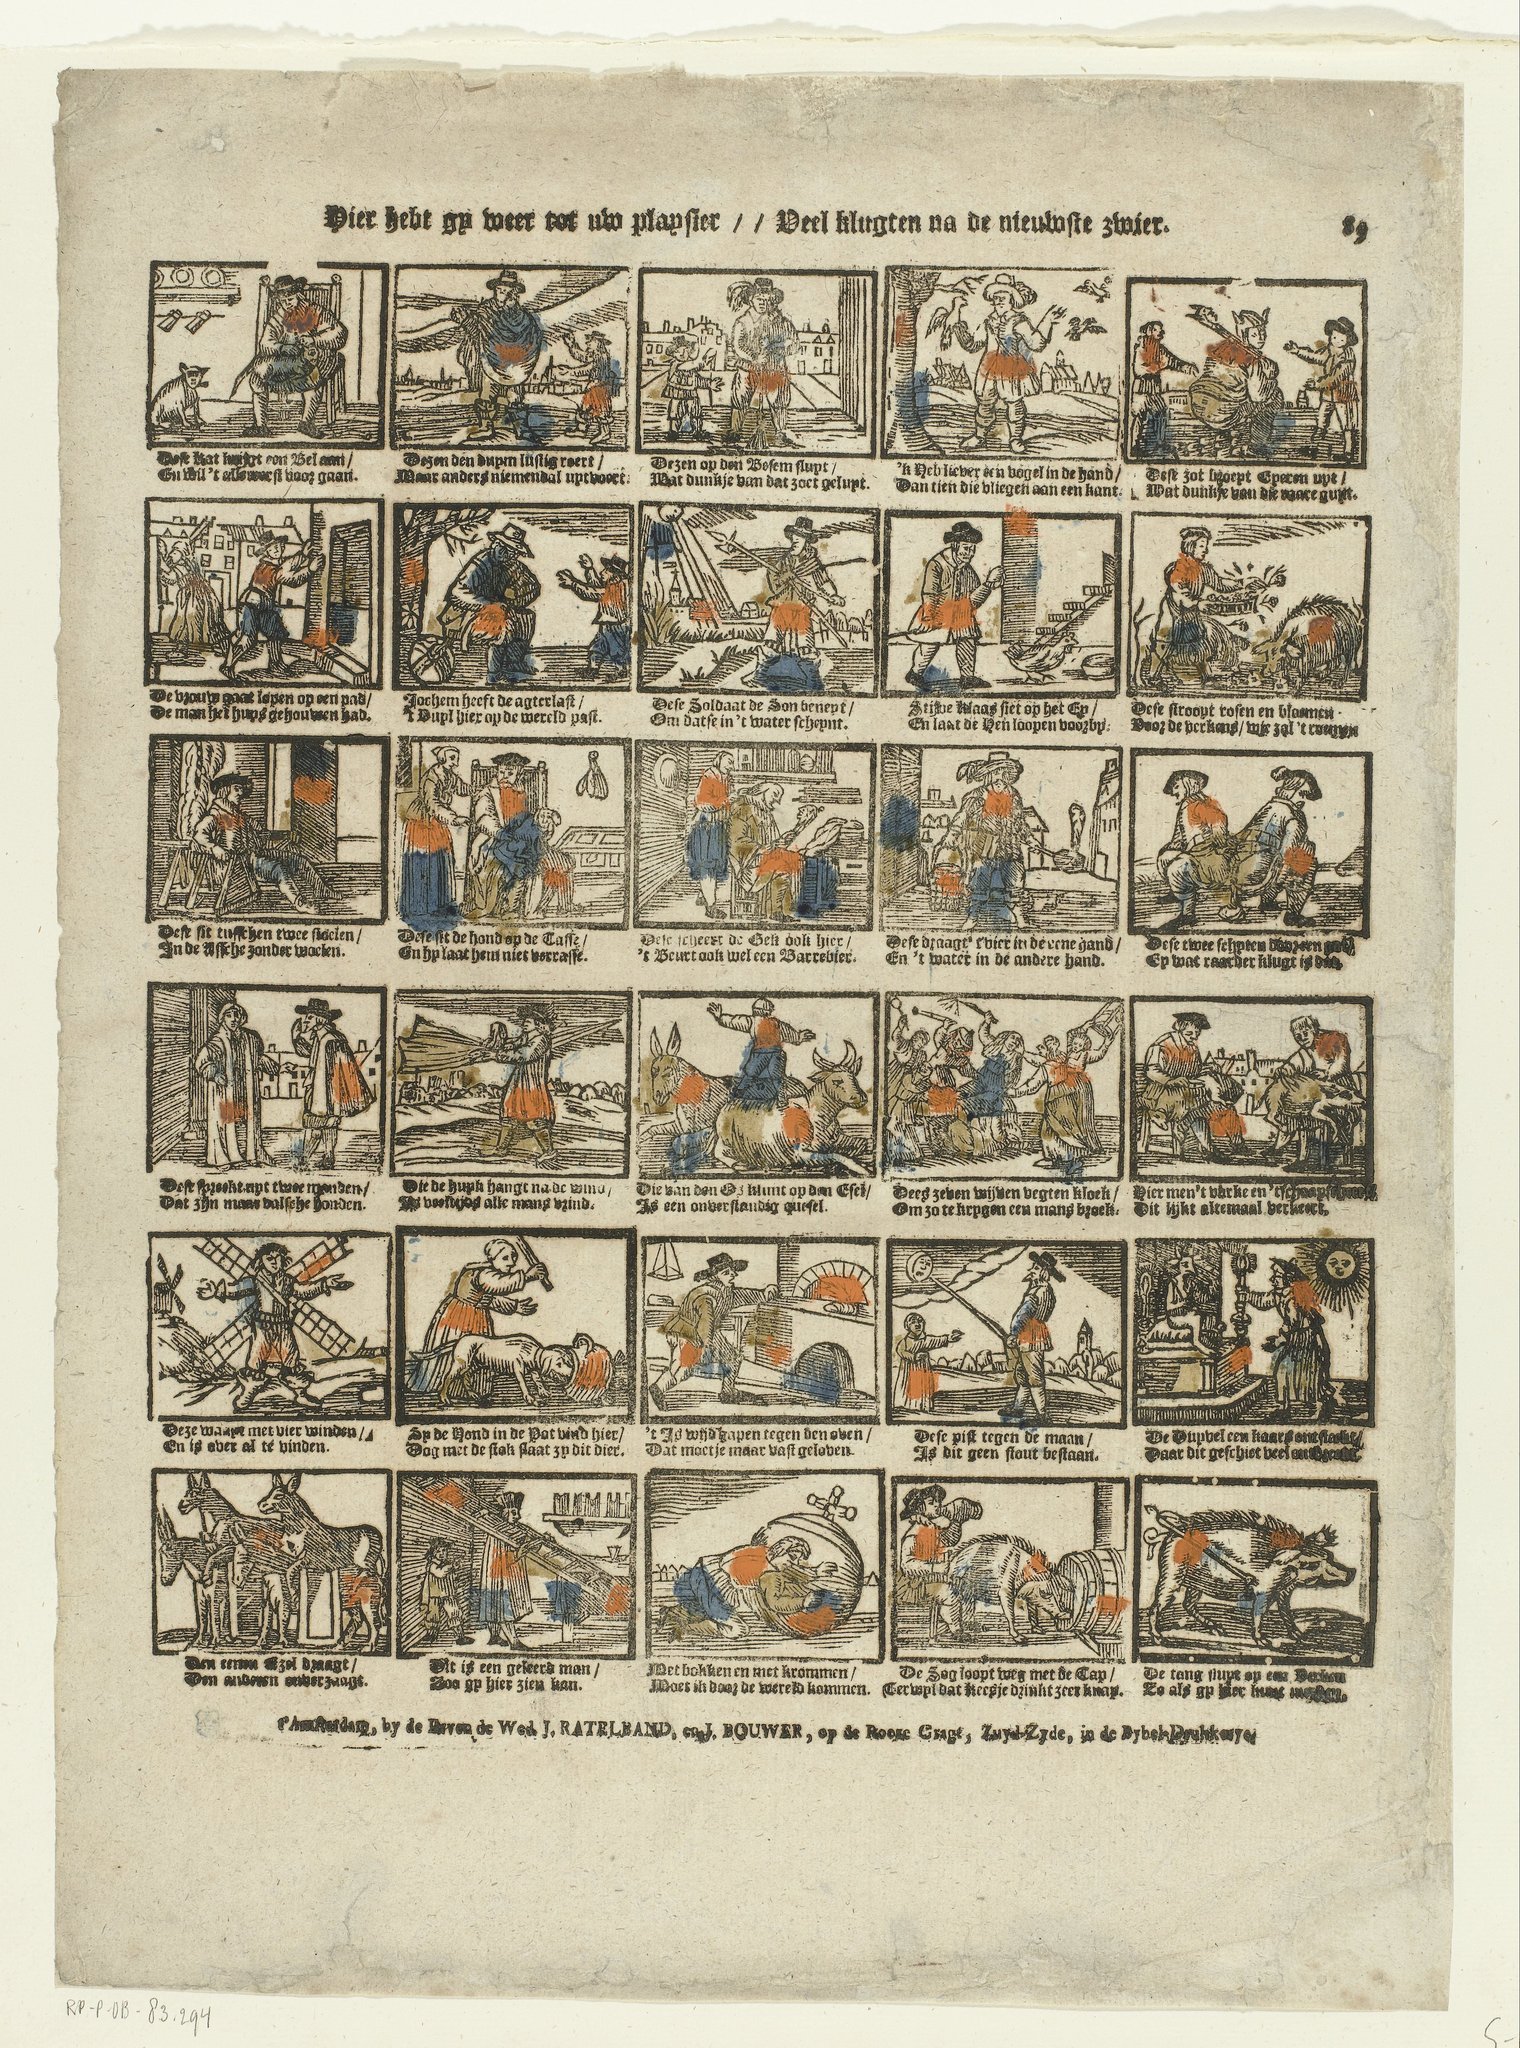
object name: print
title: Hier hebt gy weer tot uw playsier // Veel klugten na de nieuwste zwier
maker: Anonymous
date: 1782-1793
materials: paper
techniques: colour, letterpress printing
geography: netherlands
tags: proverbs, sayings, etc.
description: Blad met 30 verbeeldingen van spreekwoorden. Onder elke afbeelding een tweeregelig vers. Genummerd rechtsboven: 89.